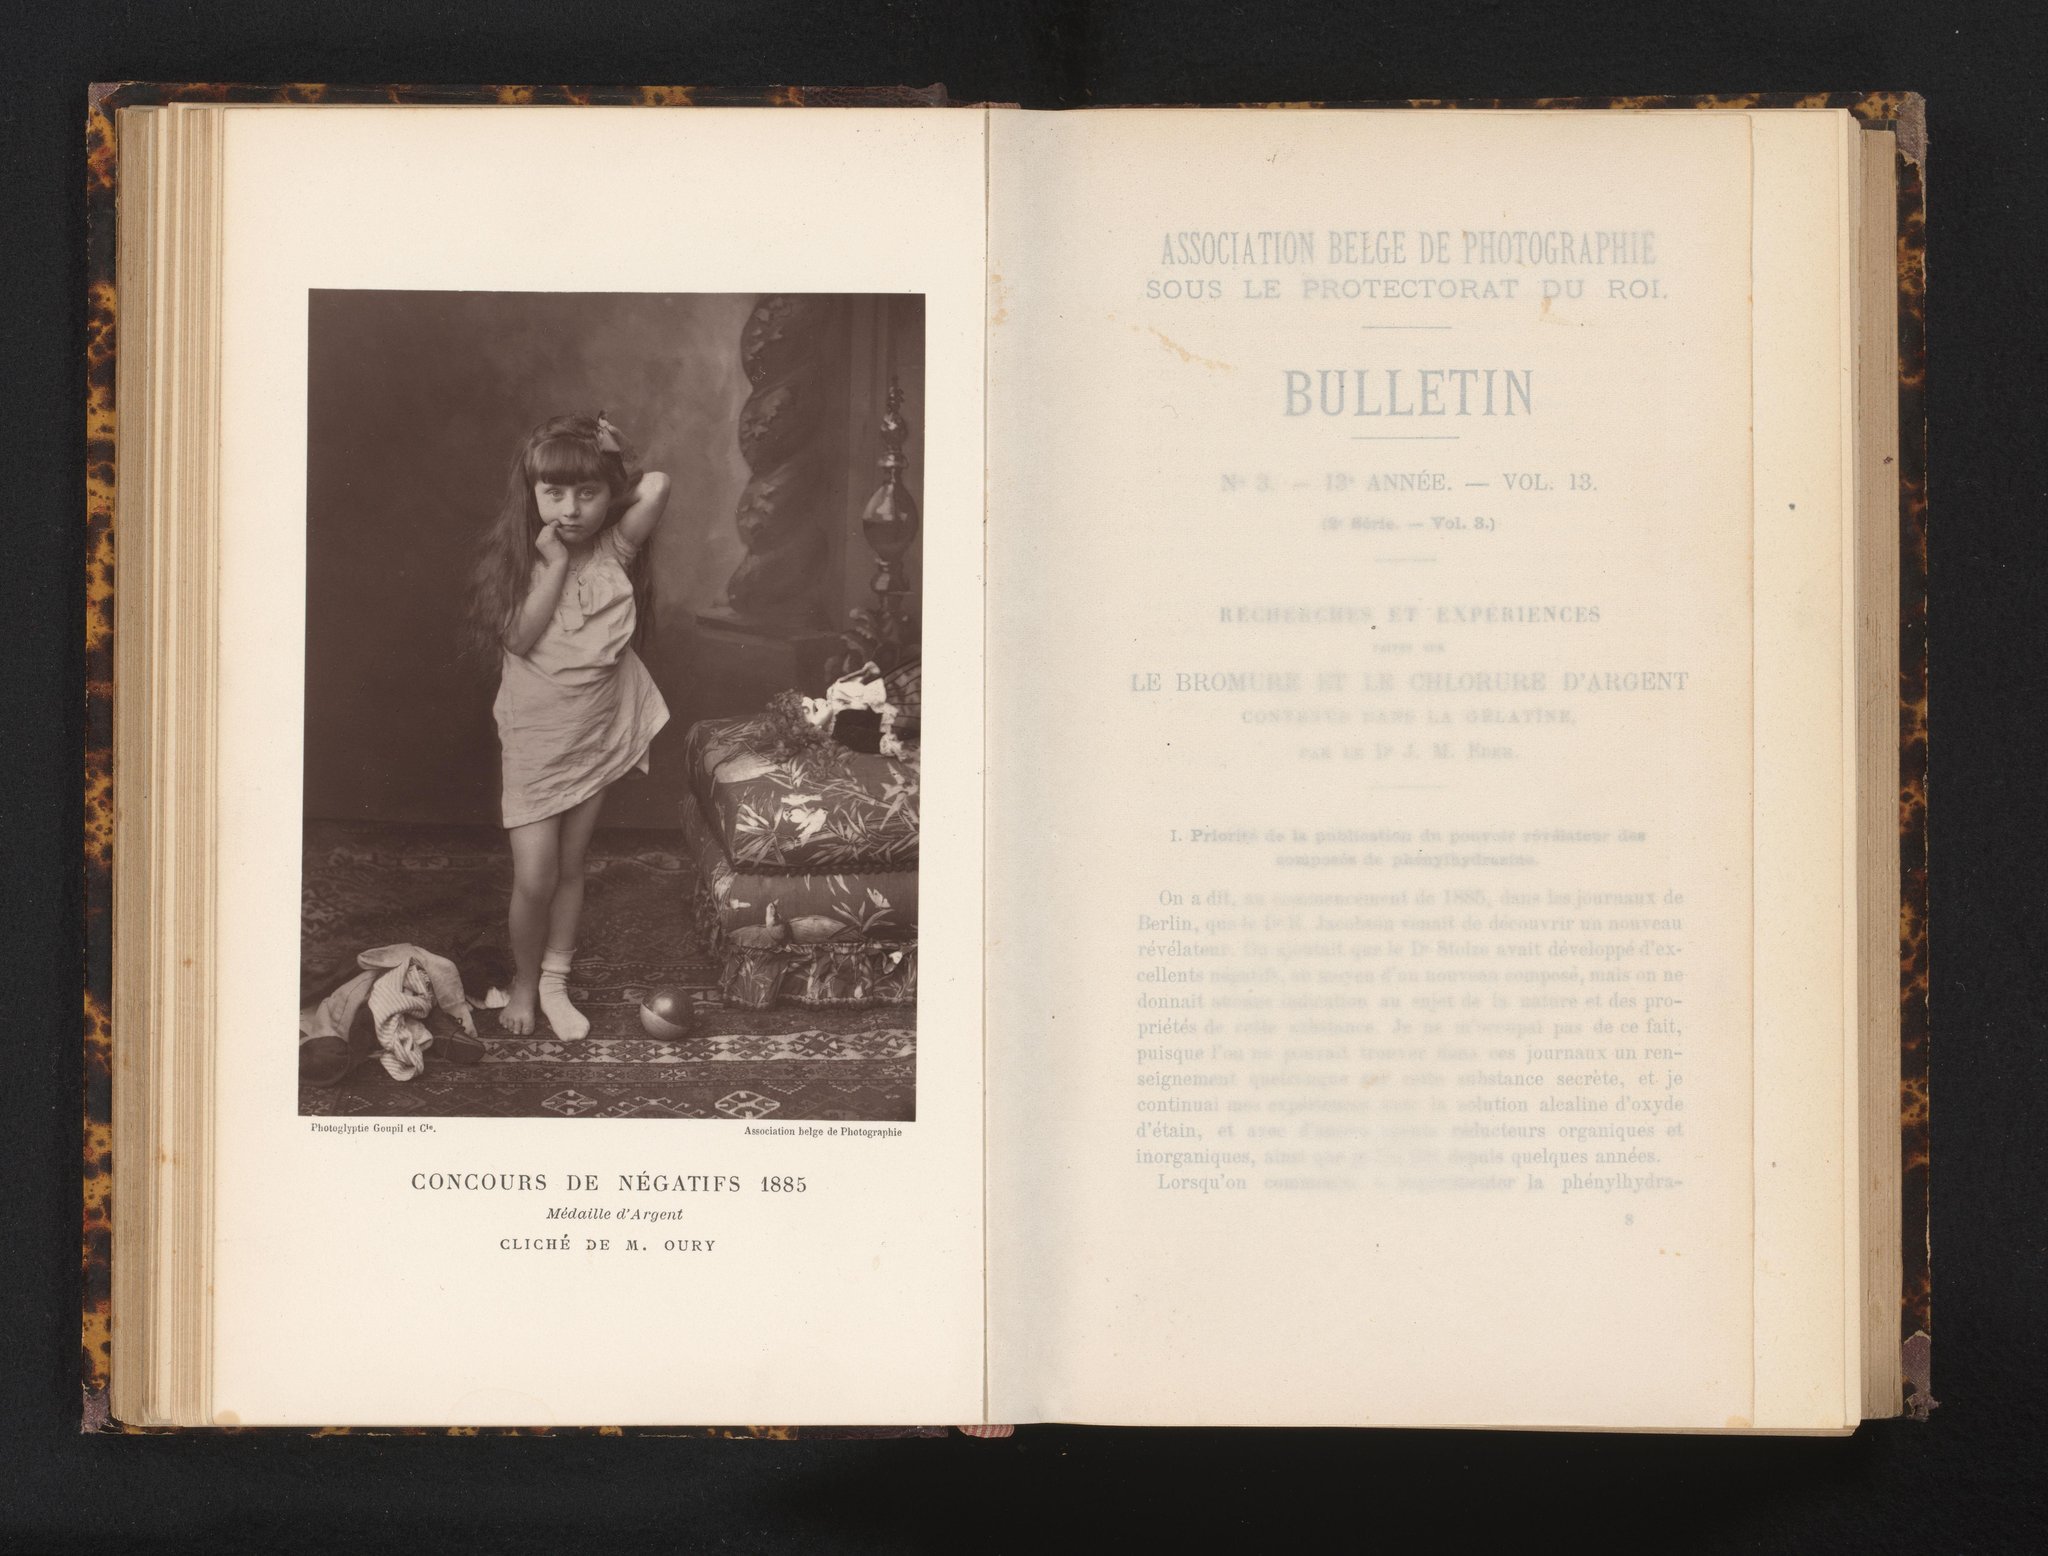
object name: photomechanical print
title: Concours de négatifs 1885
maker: guillaume oury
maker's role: amateurfotograaf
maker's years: 1840-1922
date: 1881-1886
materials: paper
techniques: woodburytype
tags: girl (child between toddler and youth), (playing with) dolls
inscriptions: inscription: ‘Association belge de Photographie’, inscription: ‘Médaille d'Argent’